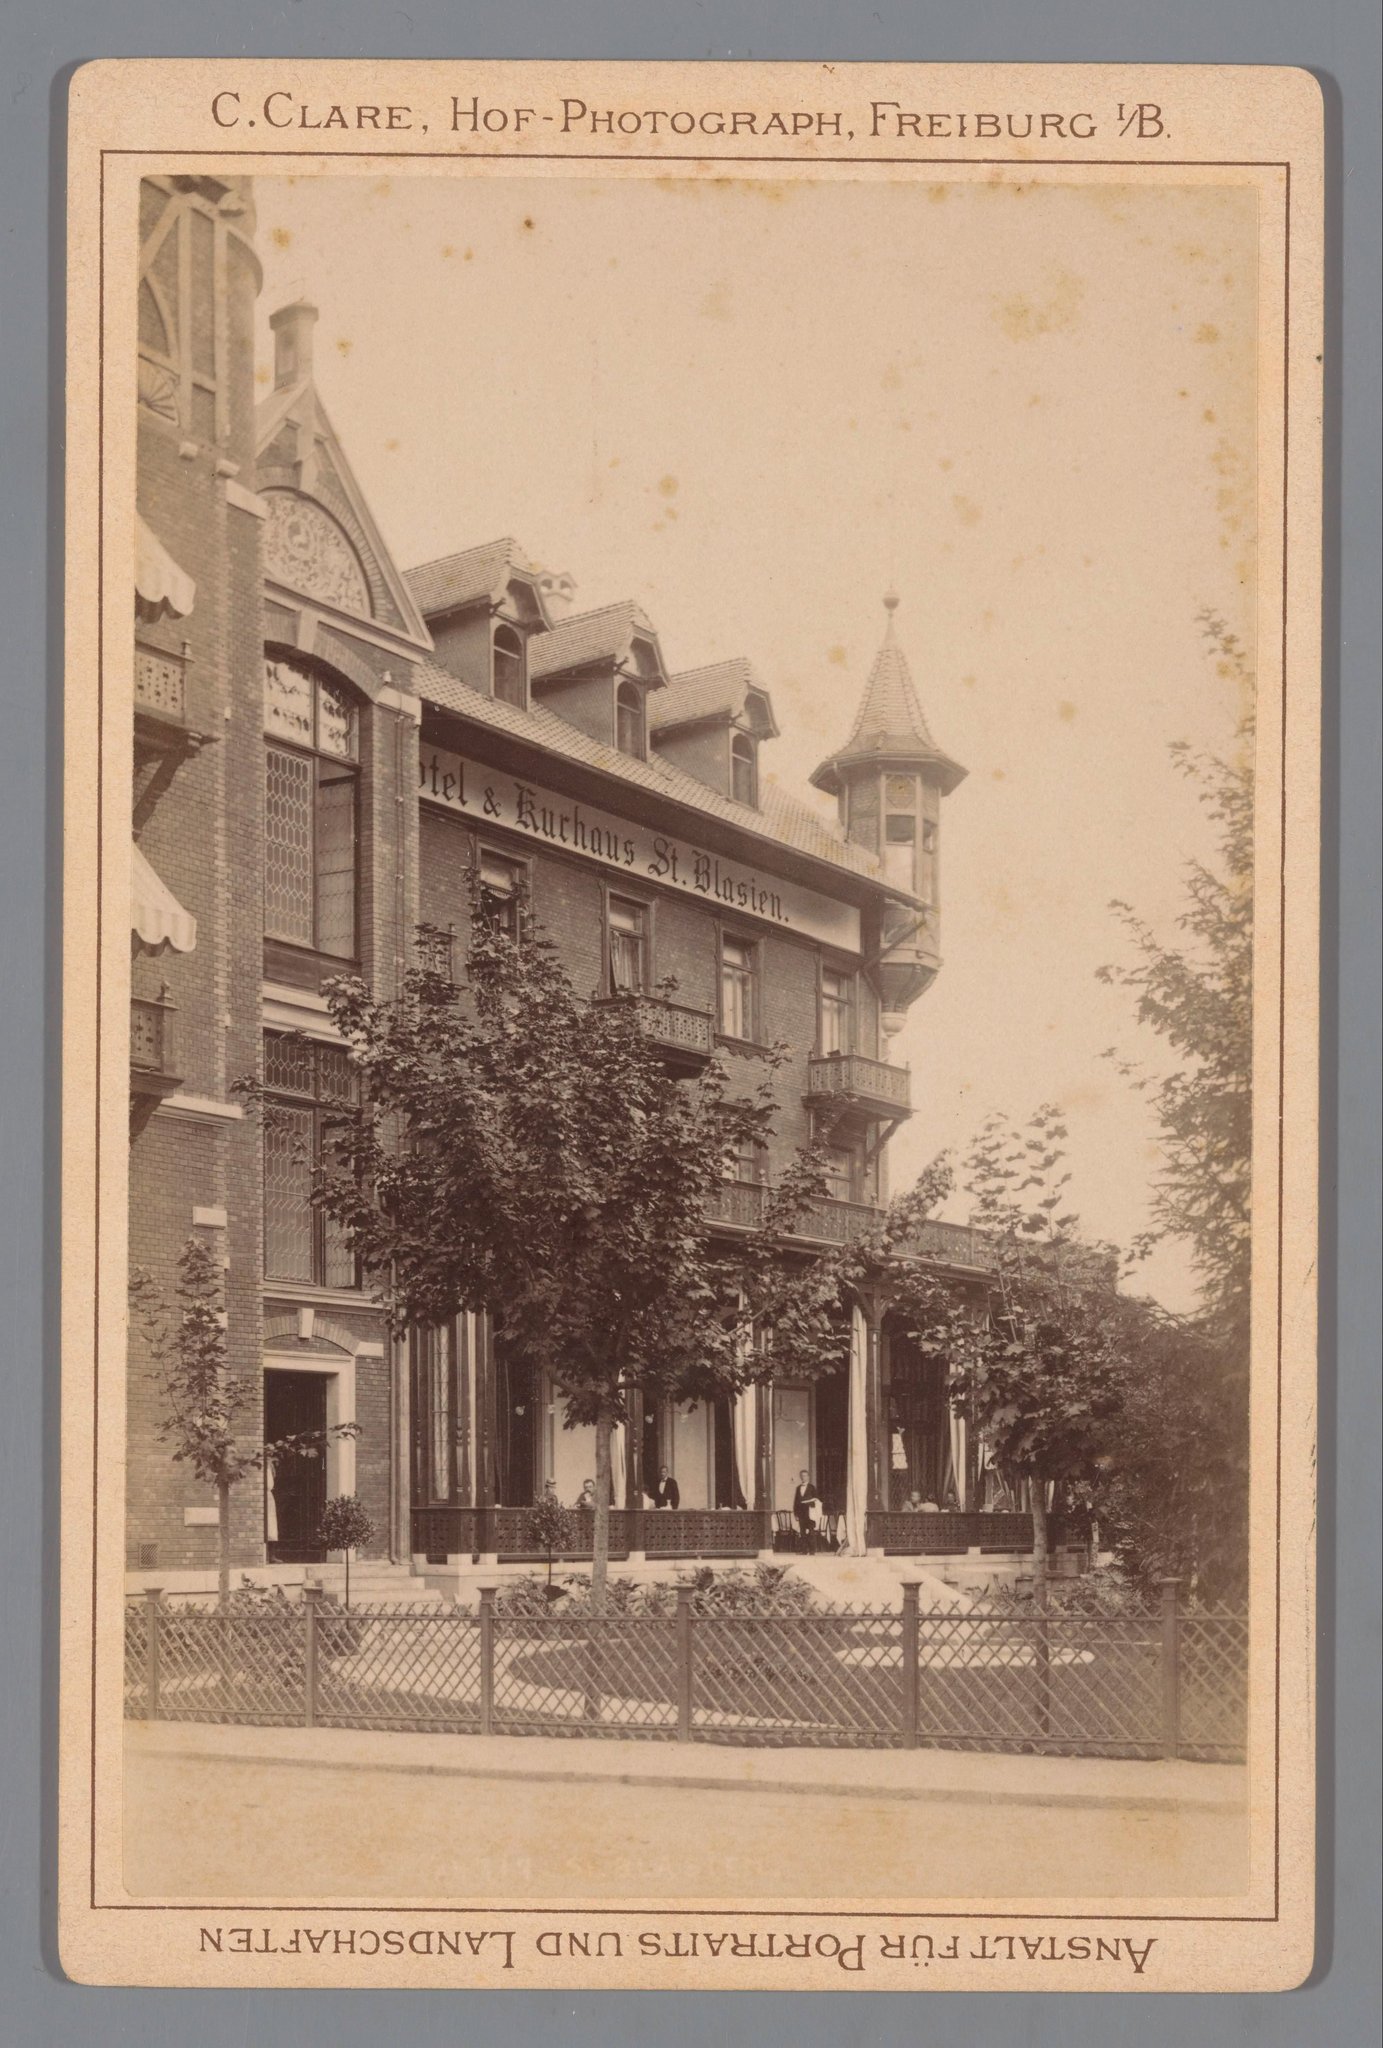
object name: cabinet photograph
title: Gezicht op een hotel in Sankt Blasien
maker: c. clare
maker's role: fotograaf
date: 1889-1900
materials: cardboard, photographic support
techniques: albumen print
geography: st. blasien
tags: watering-place, spa, hotel, hostelry, inn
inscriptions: inscription: ‘St. Blasien’, name: ‘C. Clare Hofphotograph Freiburg I/B Holzmarktplatz 10. (...)’